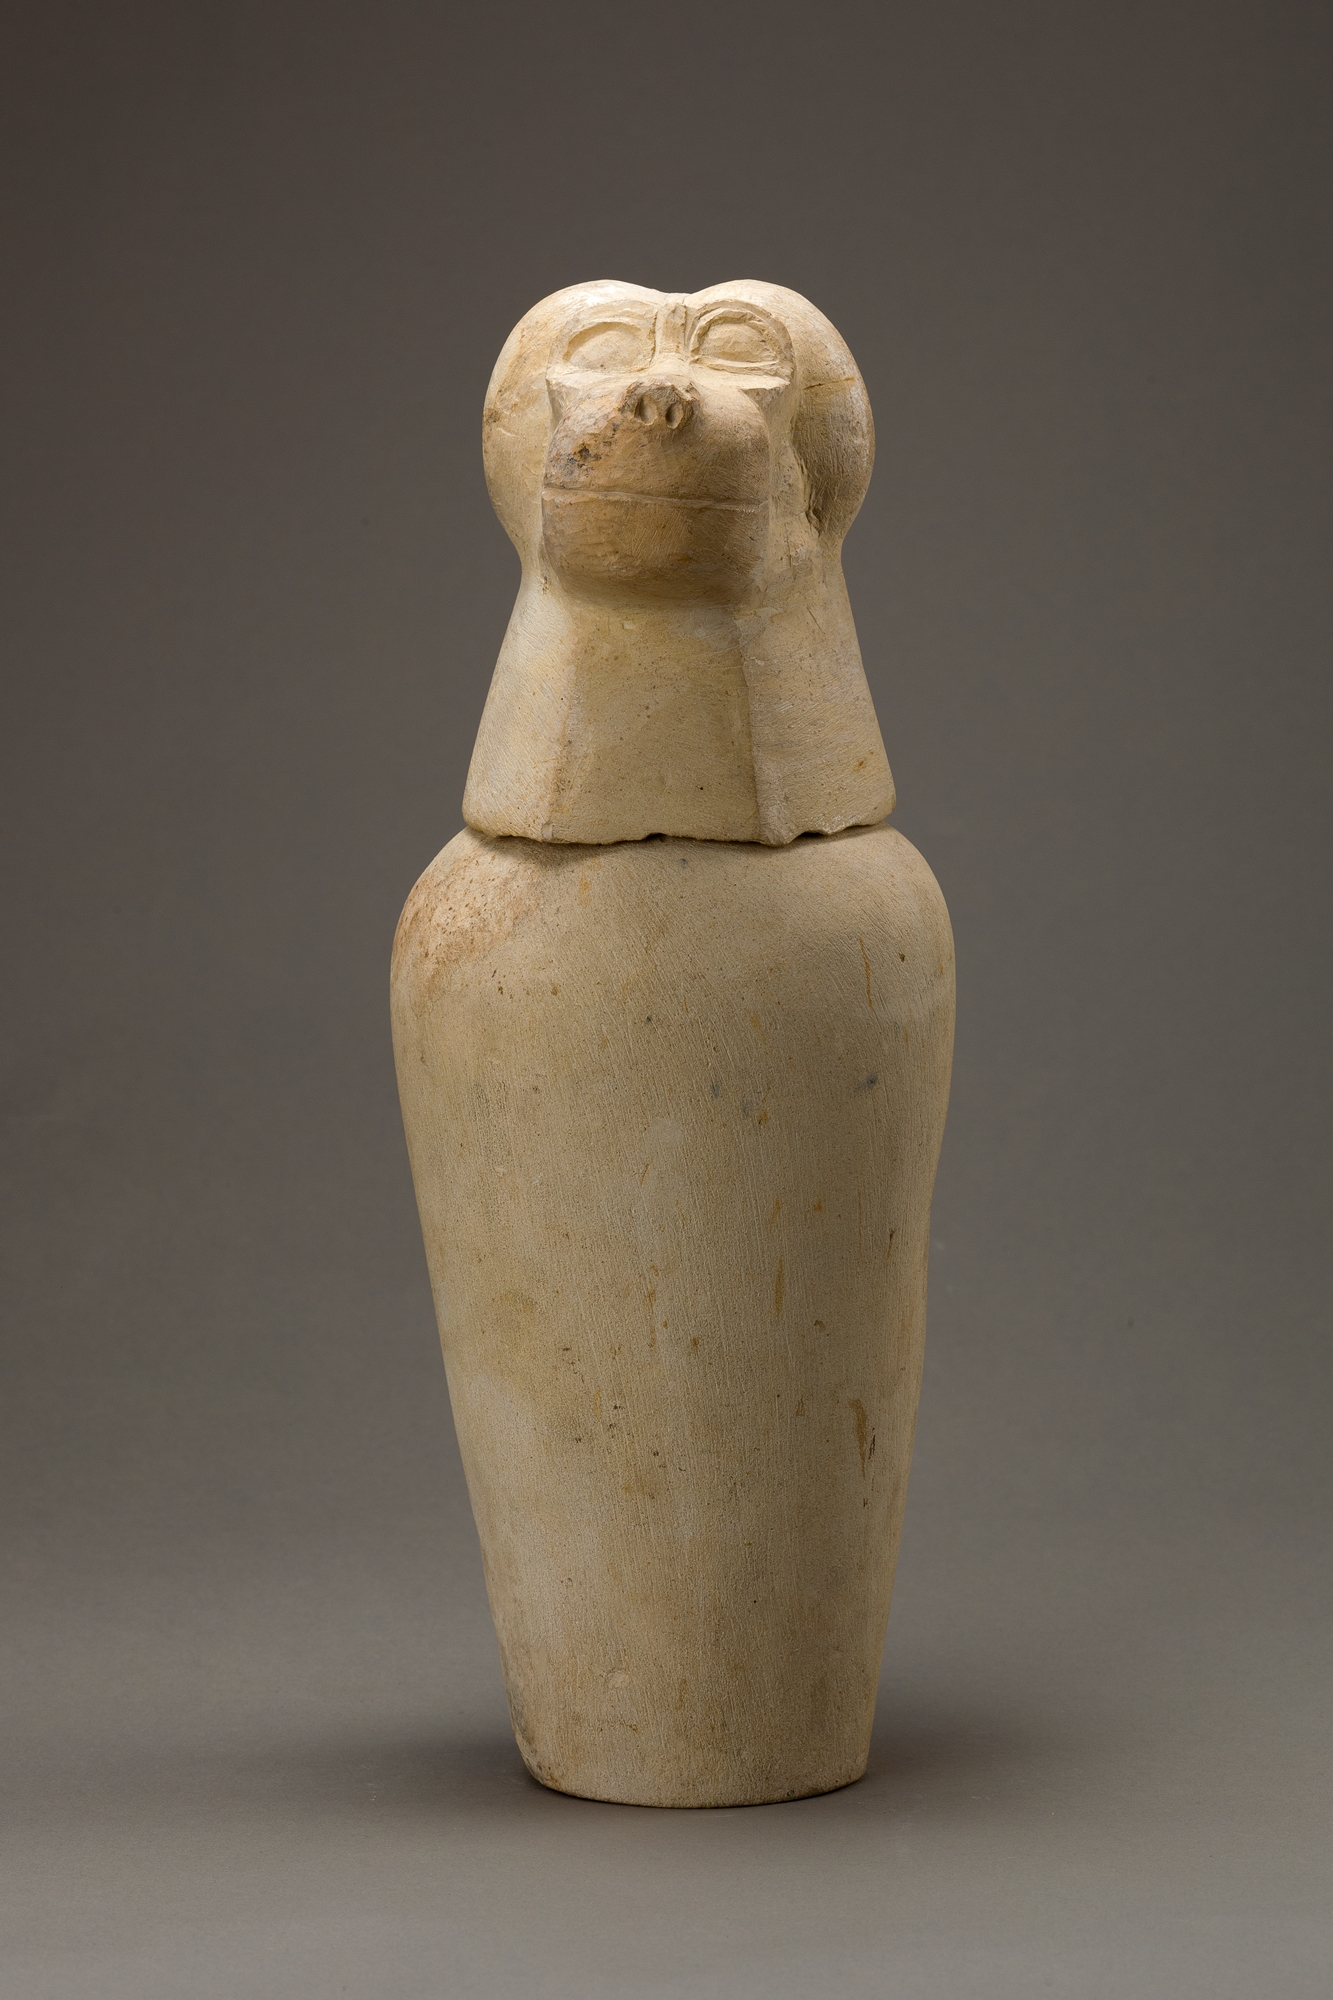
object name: canopic jar, pakherenkhonsu, baboon headed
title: Canopic jar with baboon head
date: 750-700 BCE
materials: limestone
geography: egypt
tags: animals